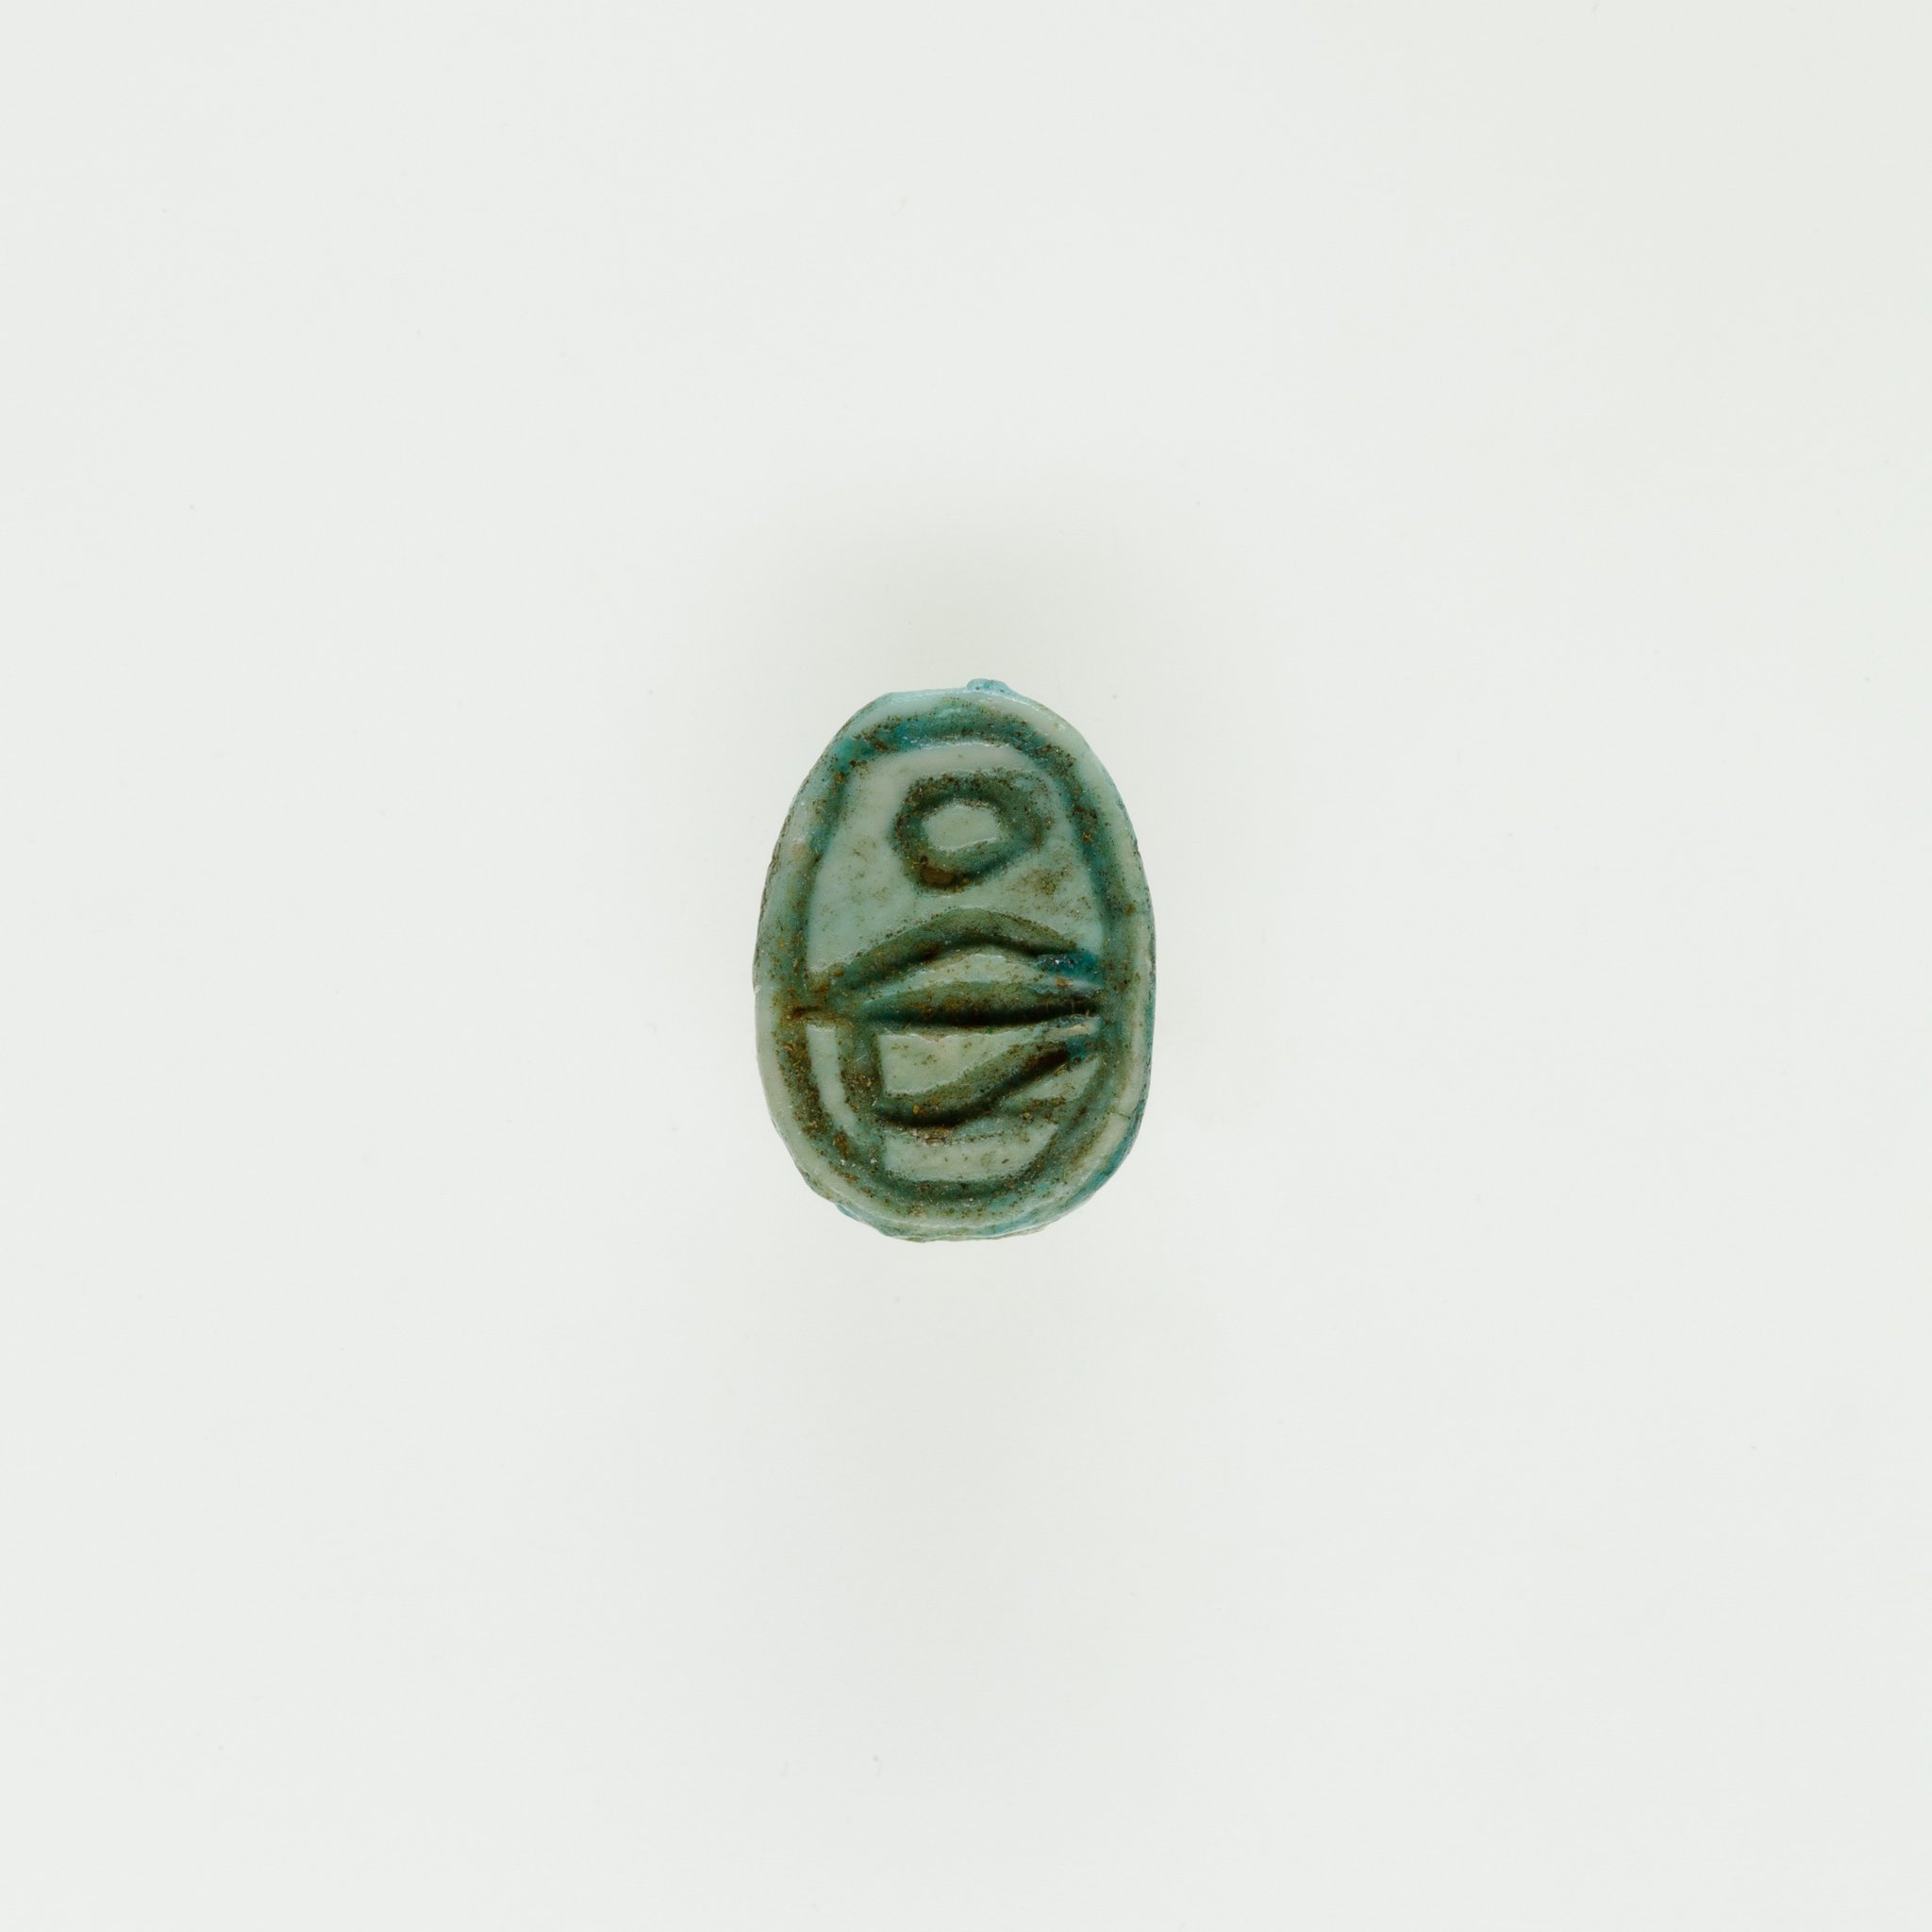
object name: scarab, may ra give, hieroglyph, re, rdi ra formula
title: Scarab Inscribed with Blessing Related to Re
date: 1850-1640 BCE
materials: faience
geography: egypt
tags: scarabs